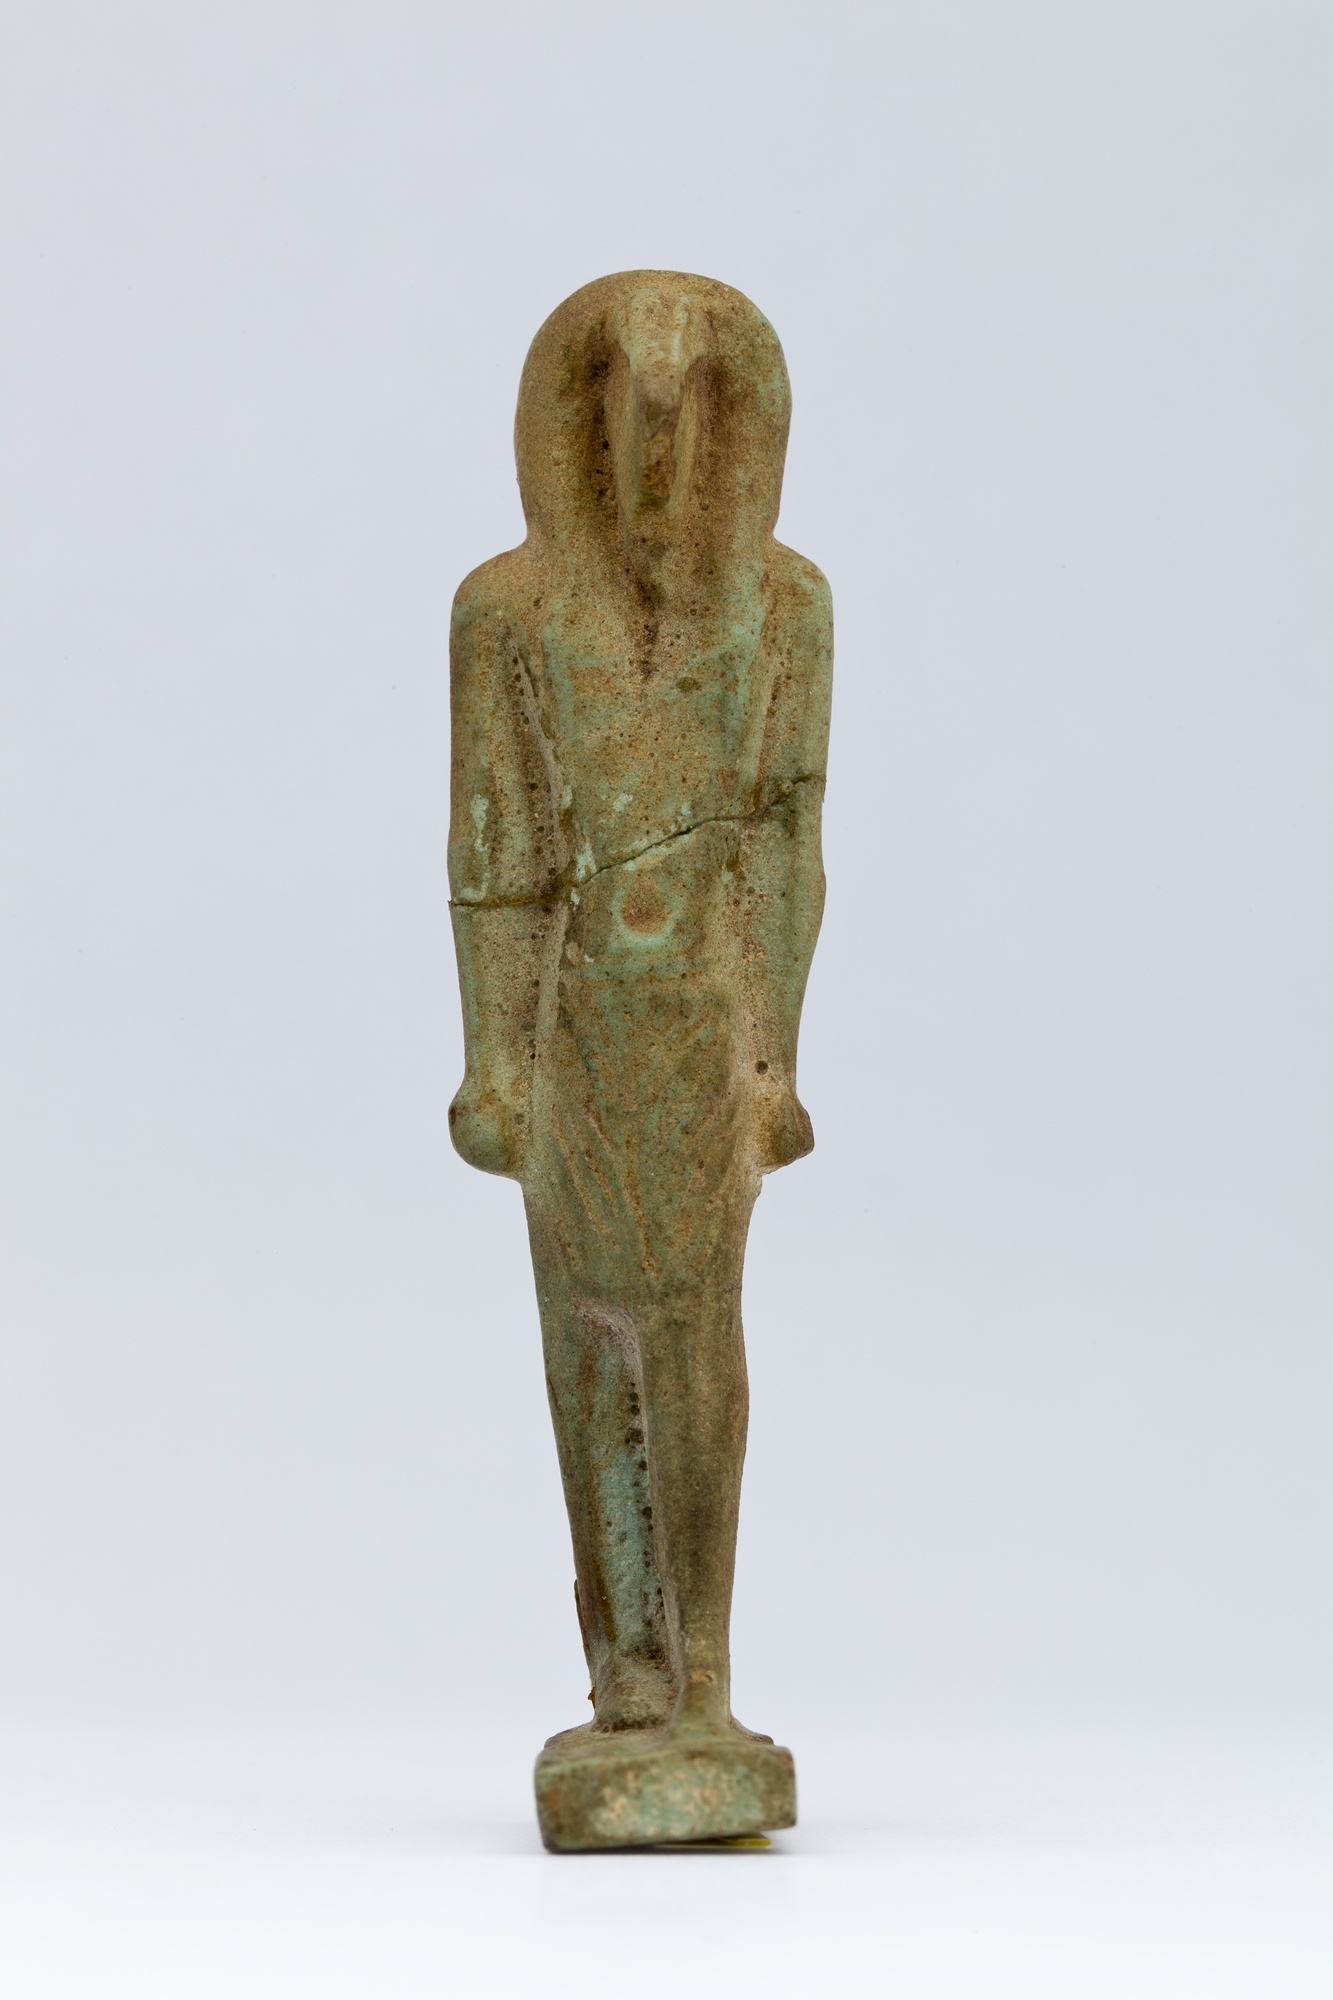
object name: amulet, thoth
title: Thoth Amulet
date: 664-630 BCE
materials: faience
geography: egypt